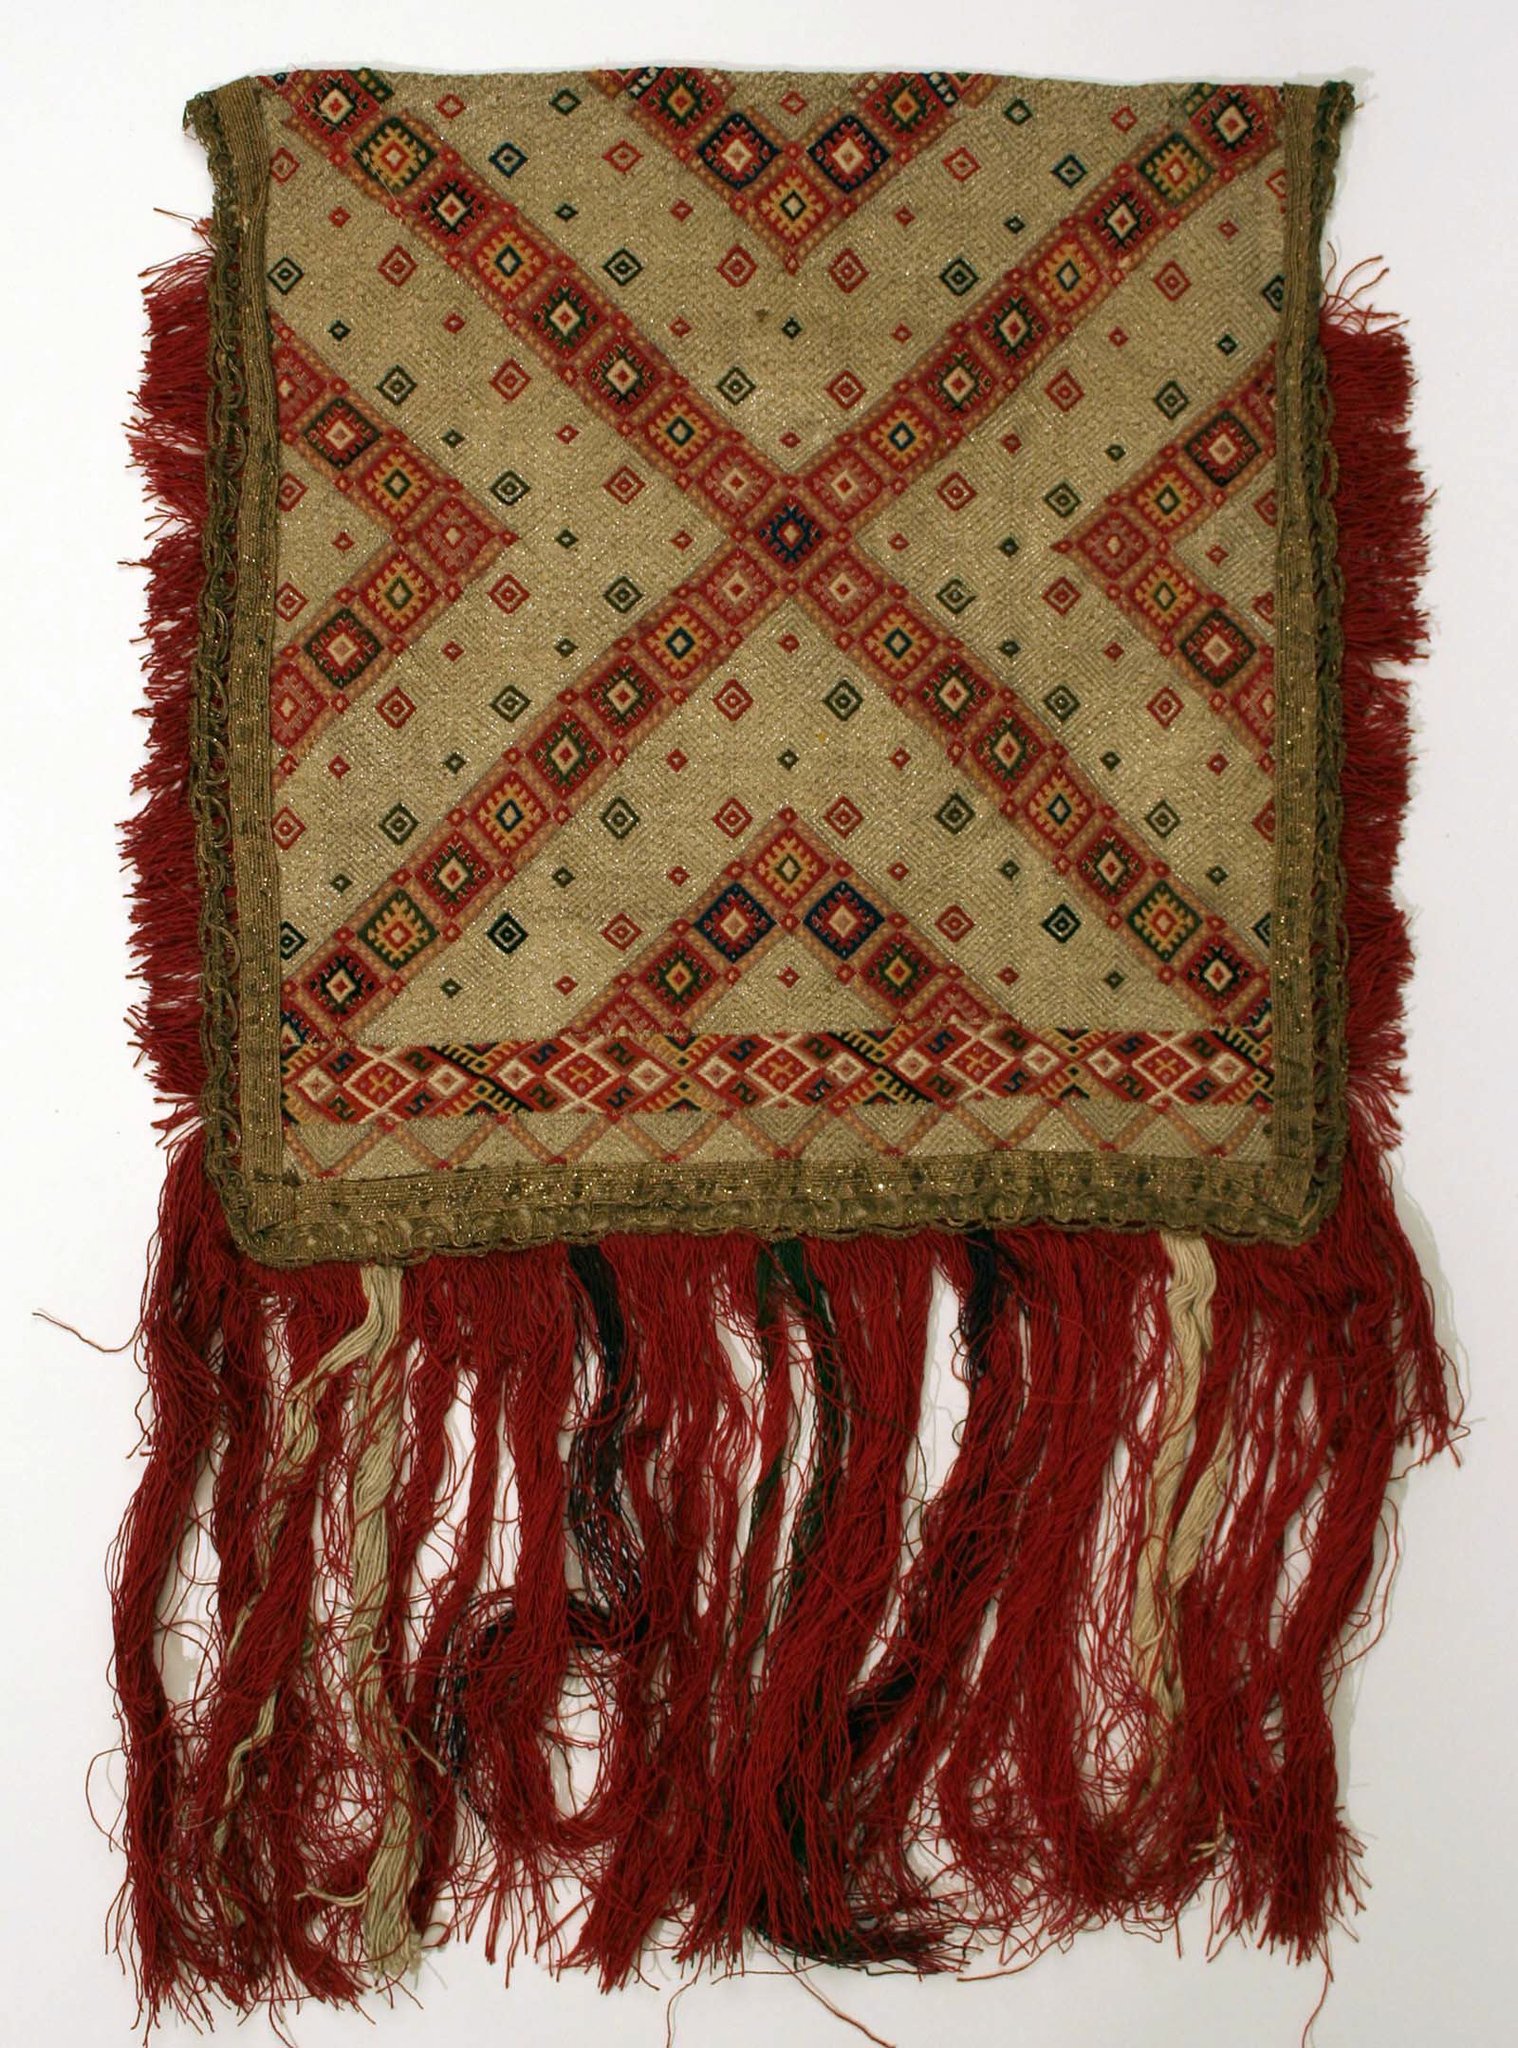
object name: apron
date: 1801-1900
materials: linen, wool